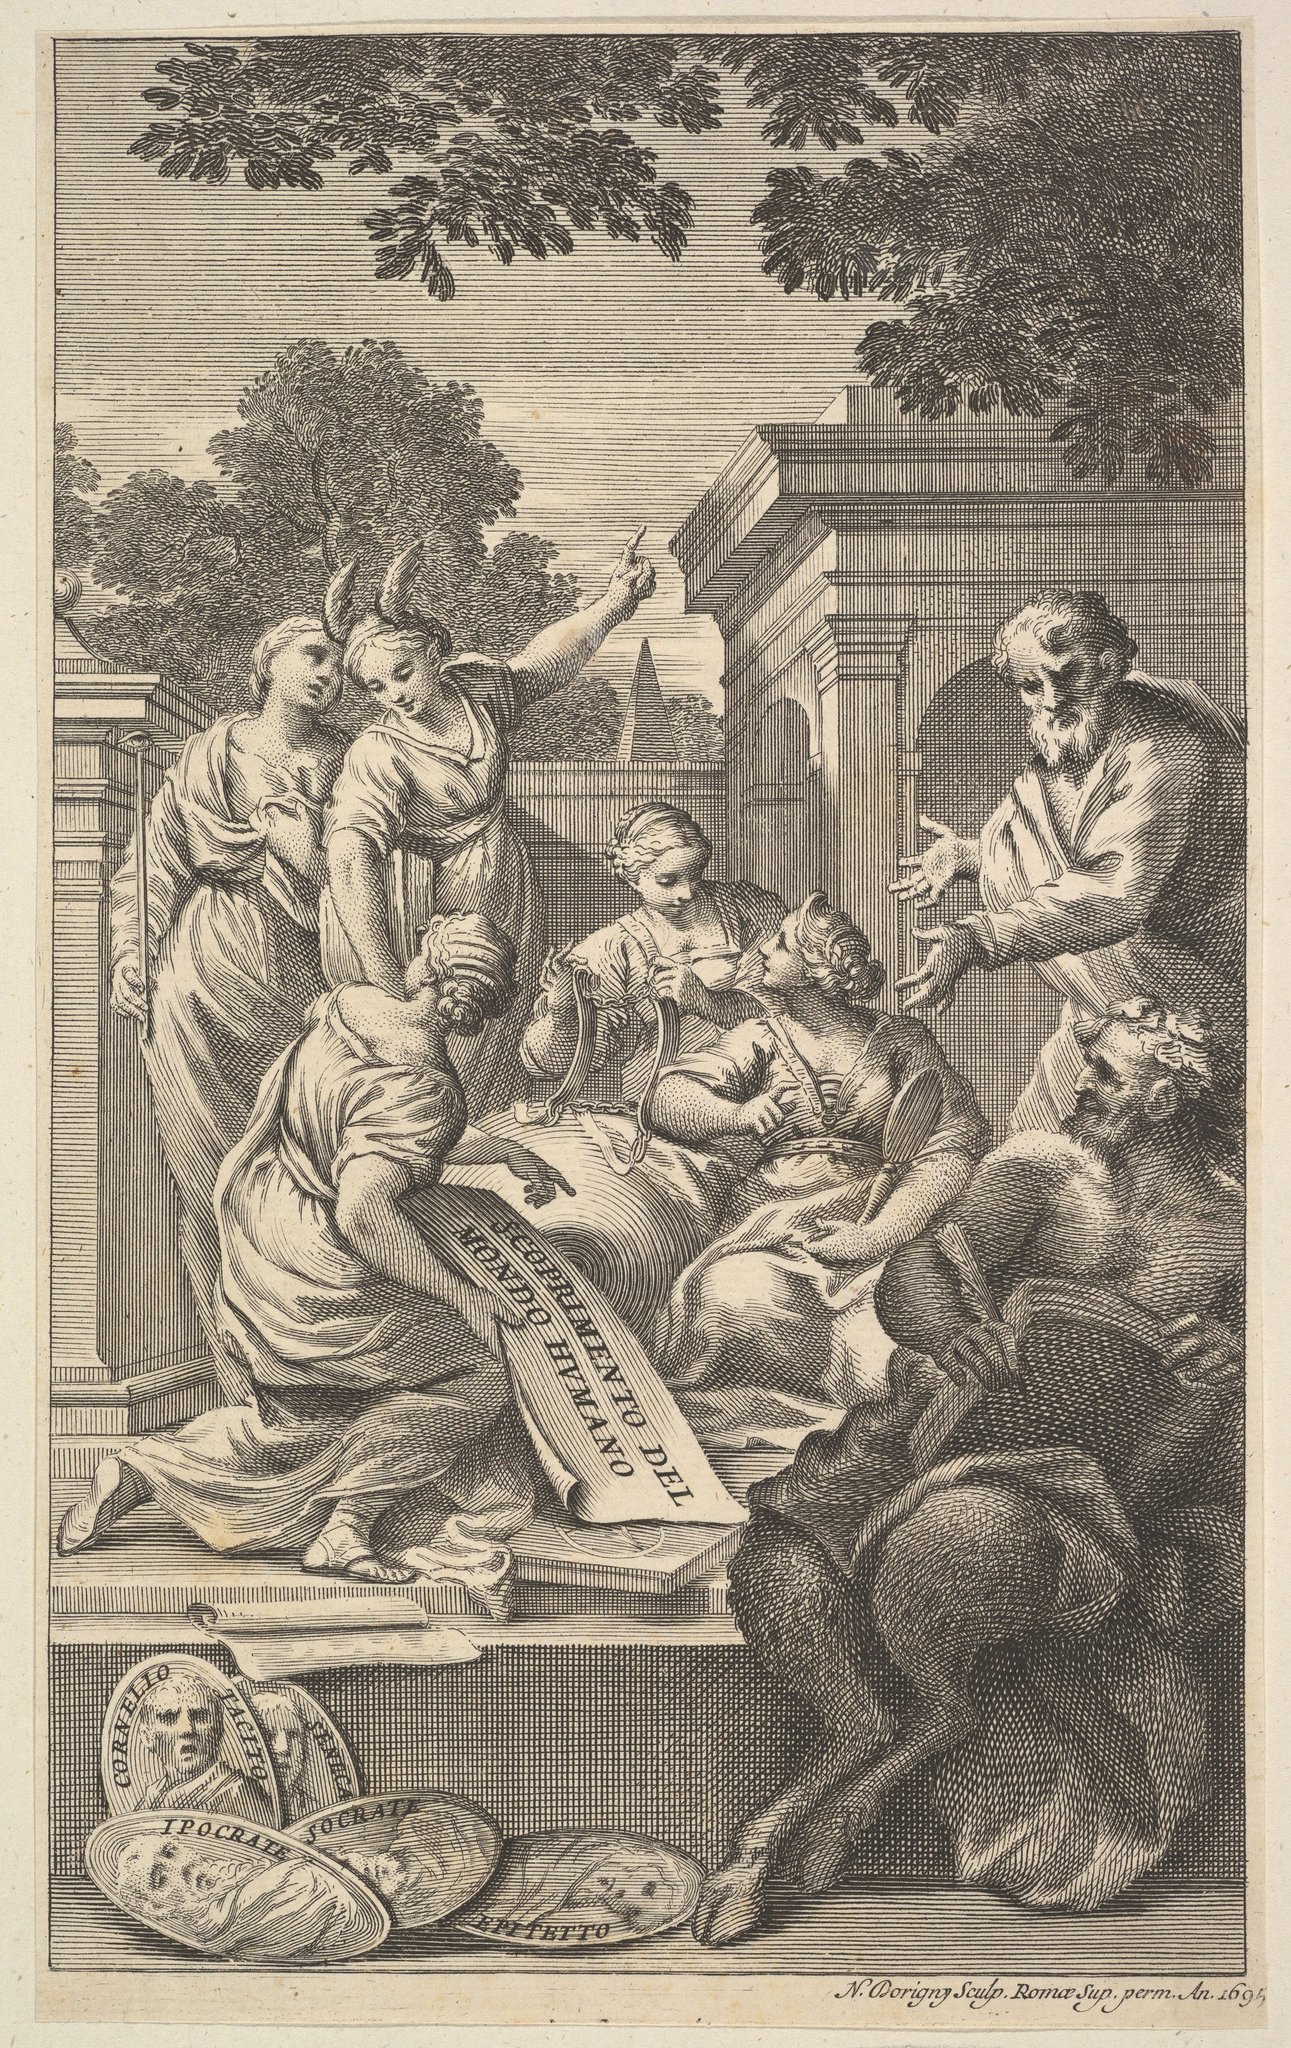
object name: print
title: Allegorical composition celebrating the Humanities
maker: sir nicolas dorigny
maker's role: artist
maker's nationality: french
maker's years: 1655-1746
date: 1695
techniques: etching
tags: men,women,satyrs